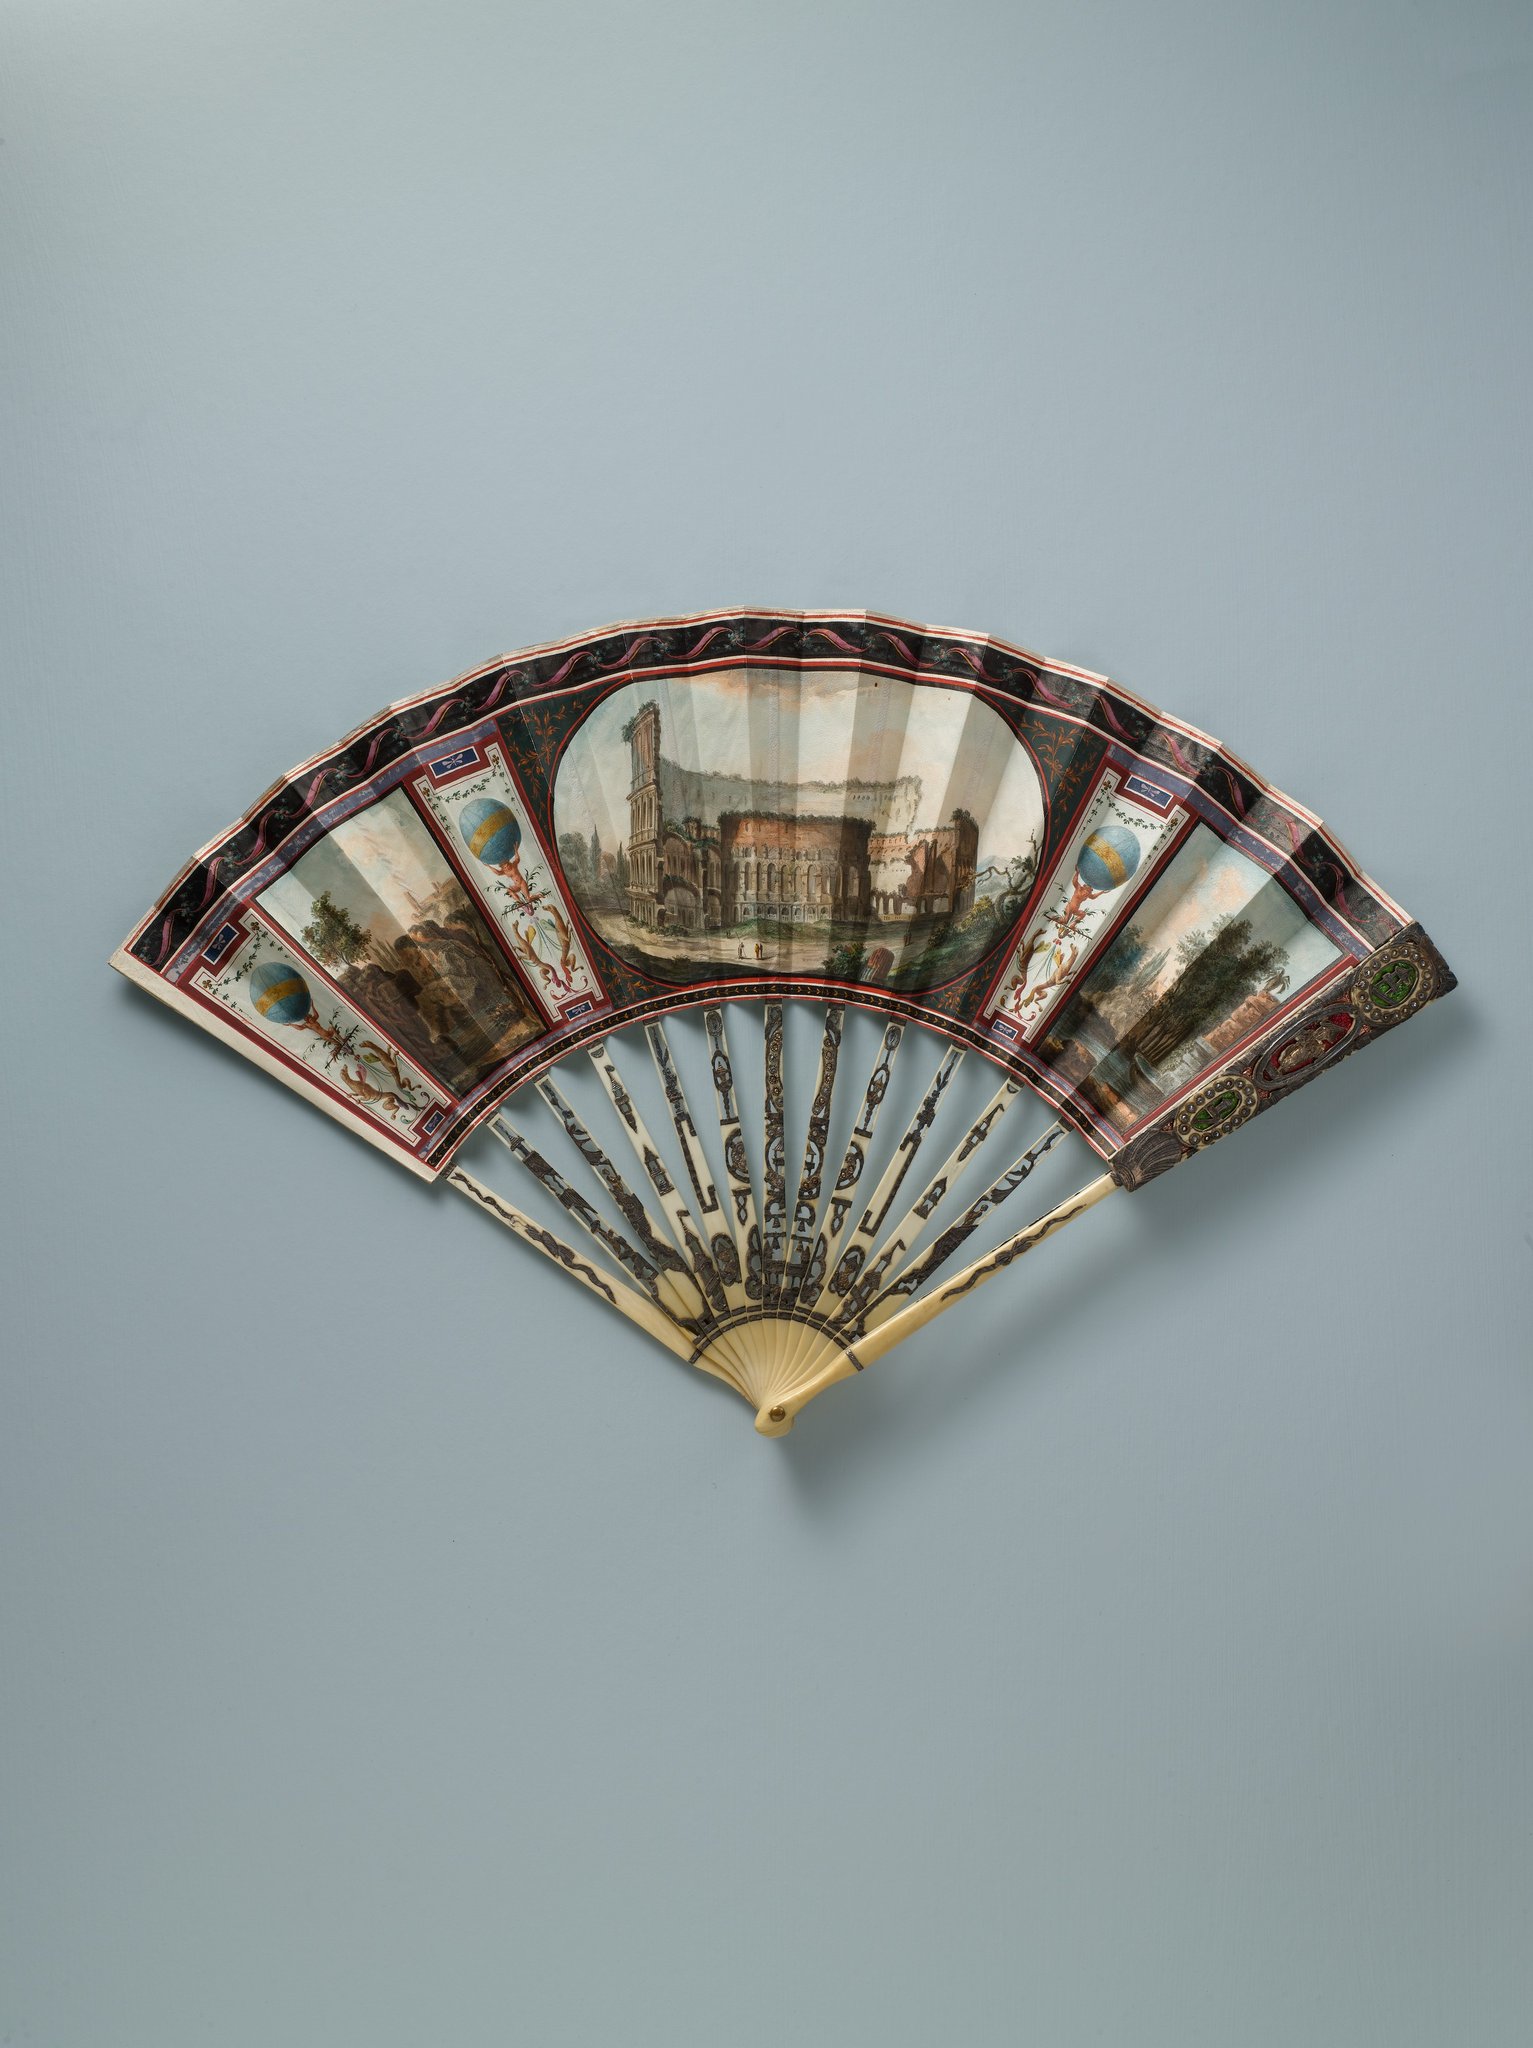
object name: fan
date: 1767-1800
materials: foil, glass, ivory, metal, paint, parchment, silver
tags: ruins